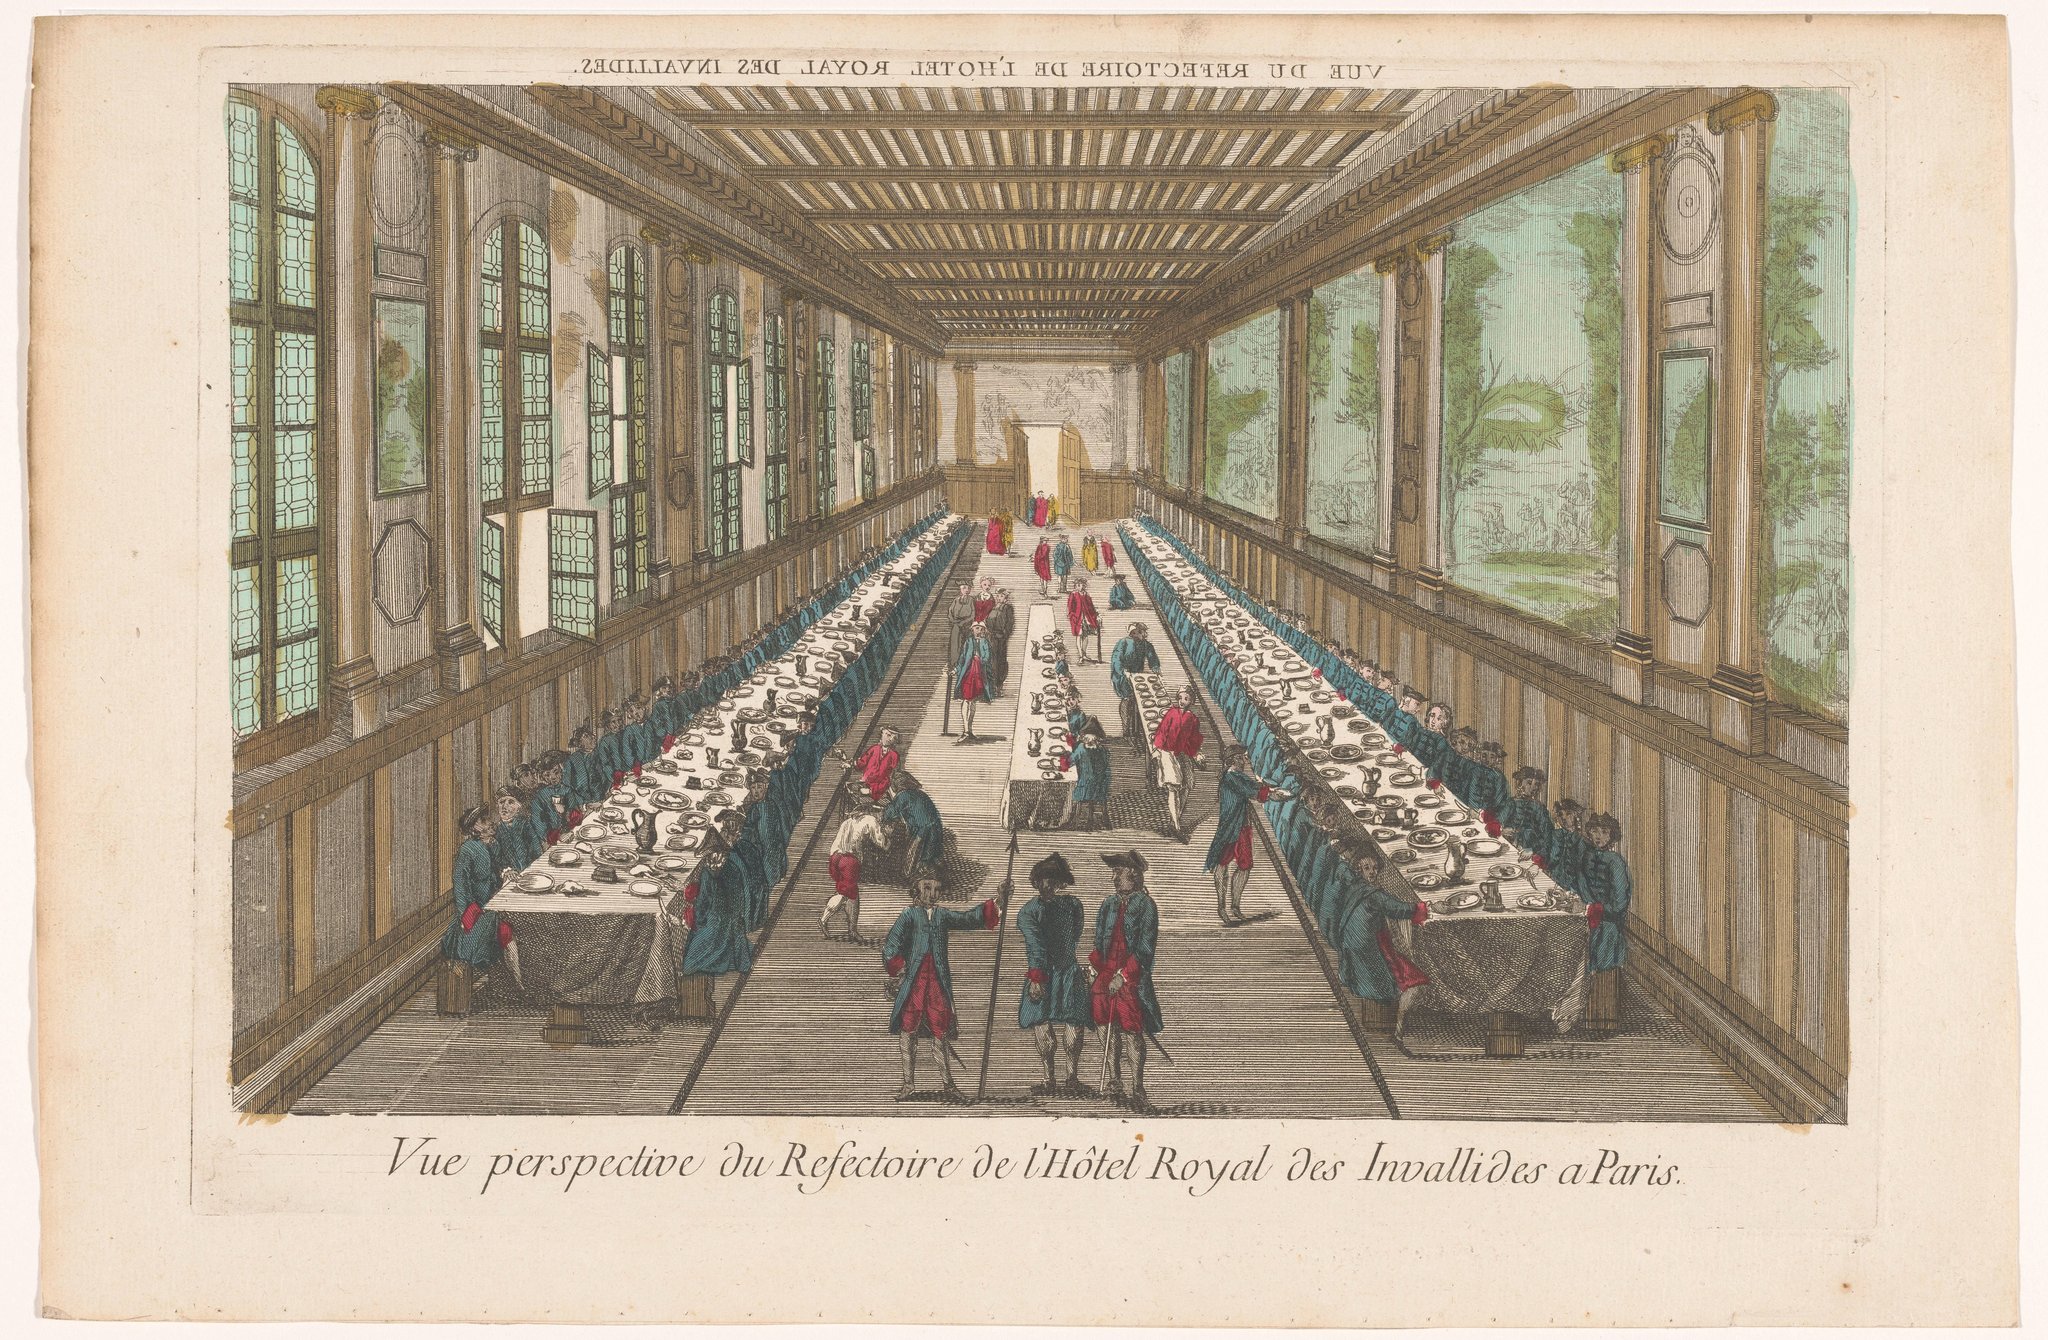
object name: opticaprent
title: Vue perspective du refectoire de l'Hôtel Royal des Invallides a Paris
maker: Anonymous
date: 1700-1799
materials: paper, watercolor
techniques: brush, etching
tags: interior ~ representation of a building, (family) meal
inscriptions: collector's mark: Lugt 2166